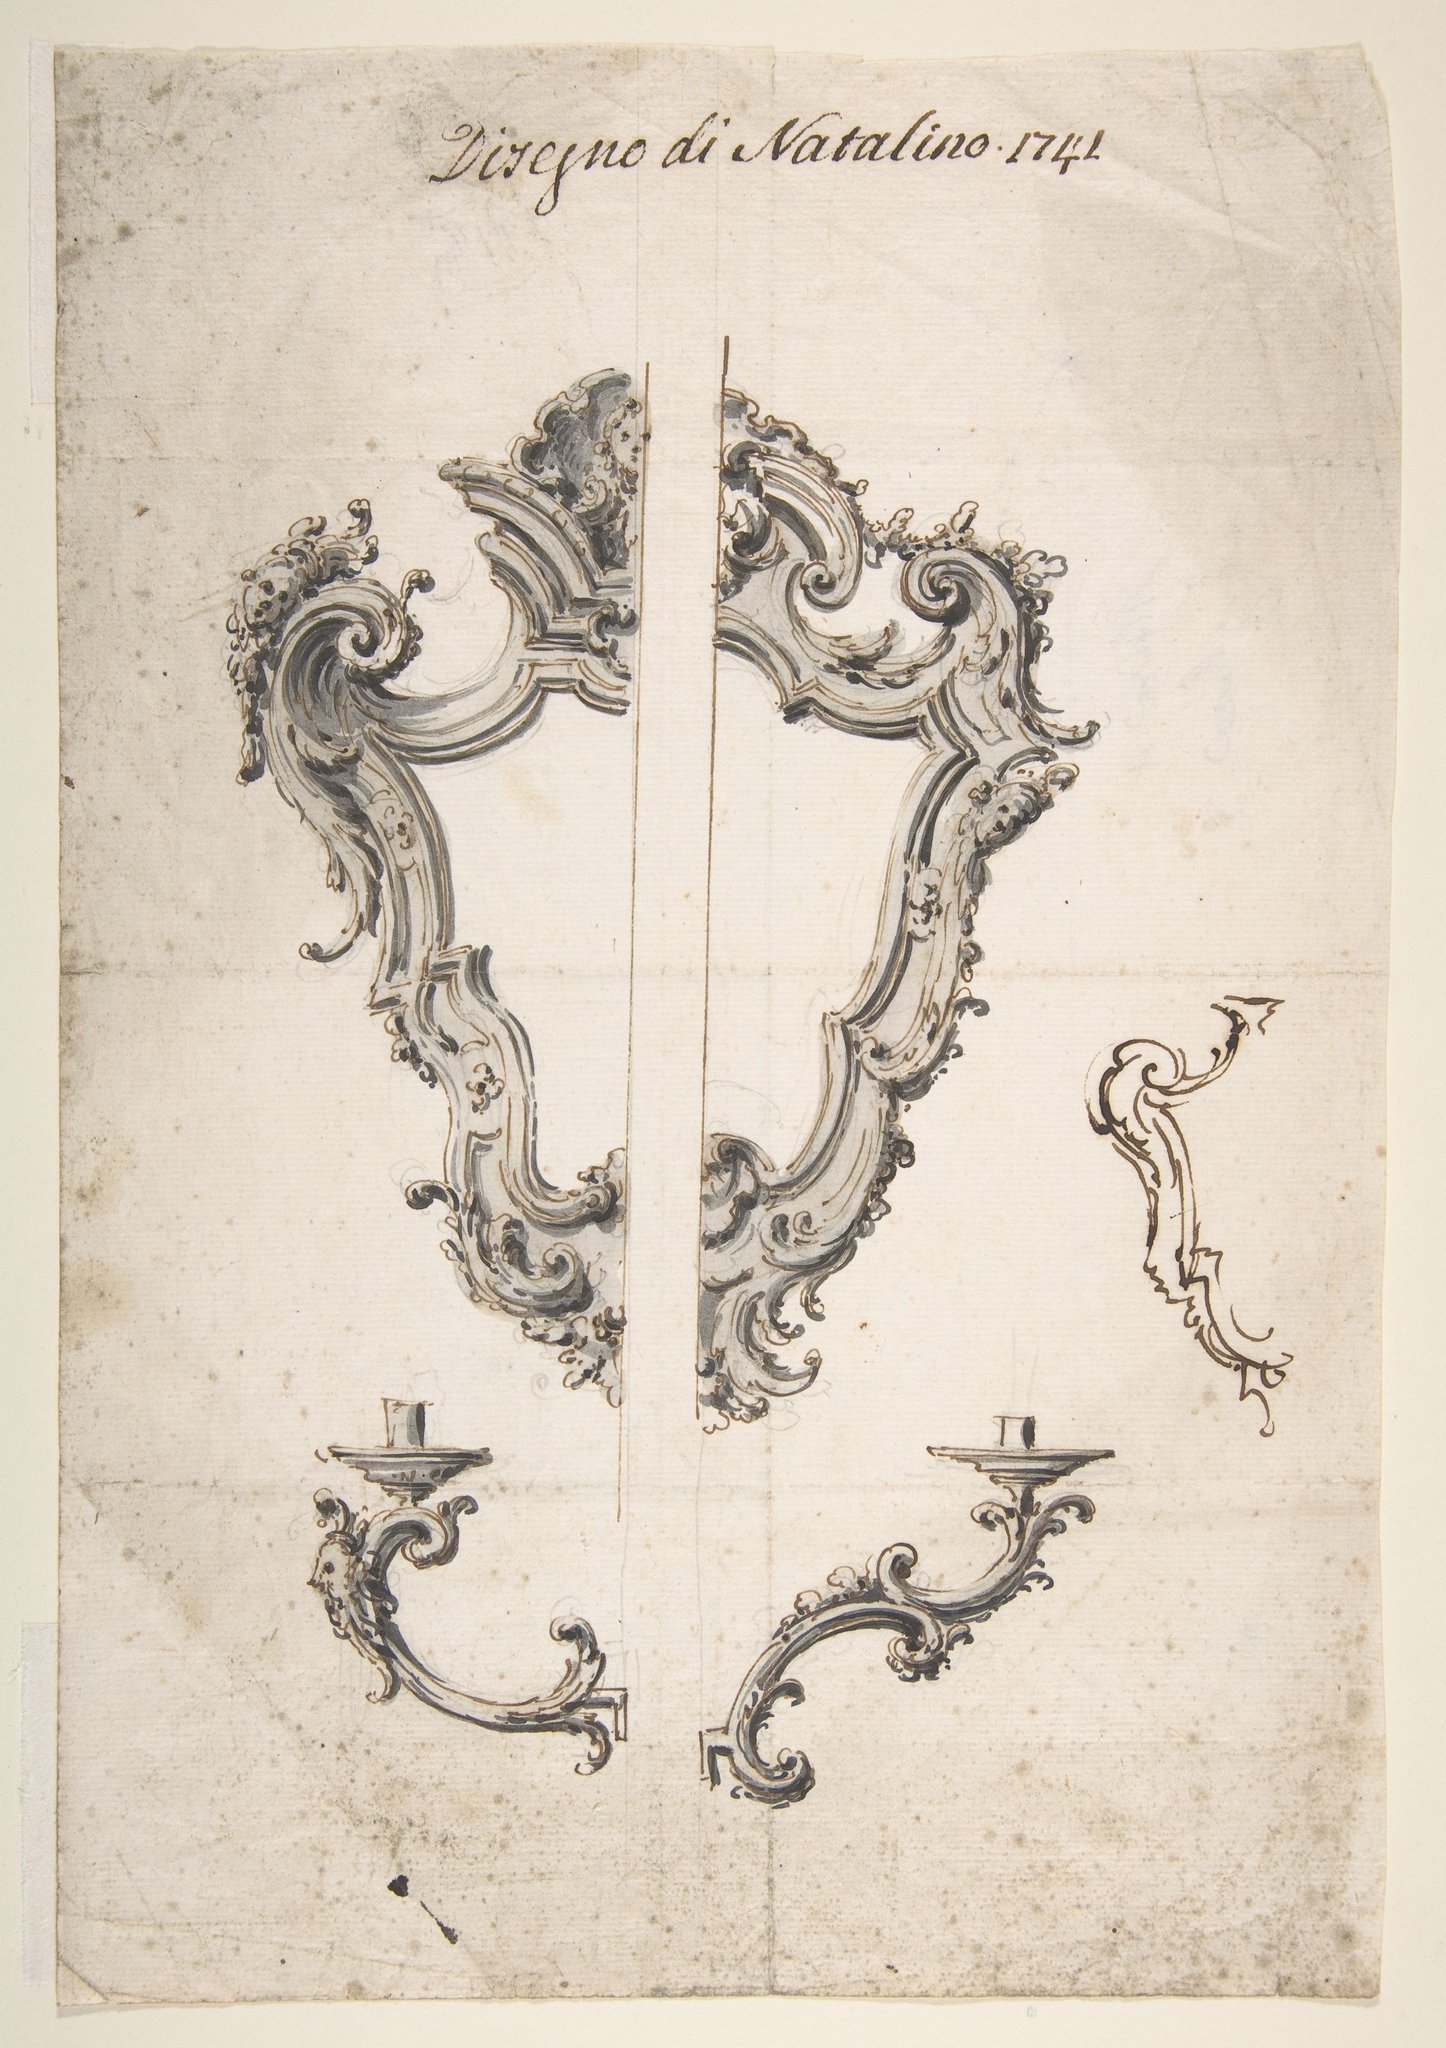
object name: drawing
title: Designs for Mirror Frames and Sconces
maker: giovanni battista natali iii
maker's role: artist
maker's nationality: italian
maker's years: 1698-1765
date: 1698-1765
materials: chalk, graphite, ink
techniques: brush, pen, wash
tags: faces